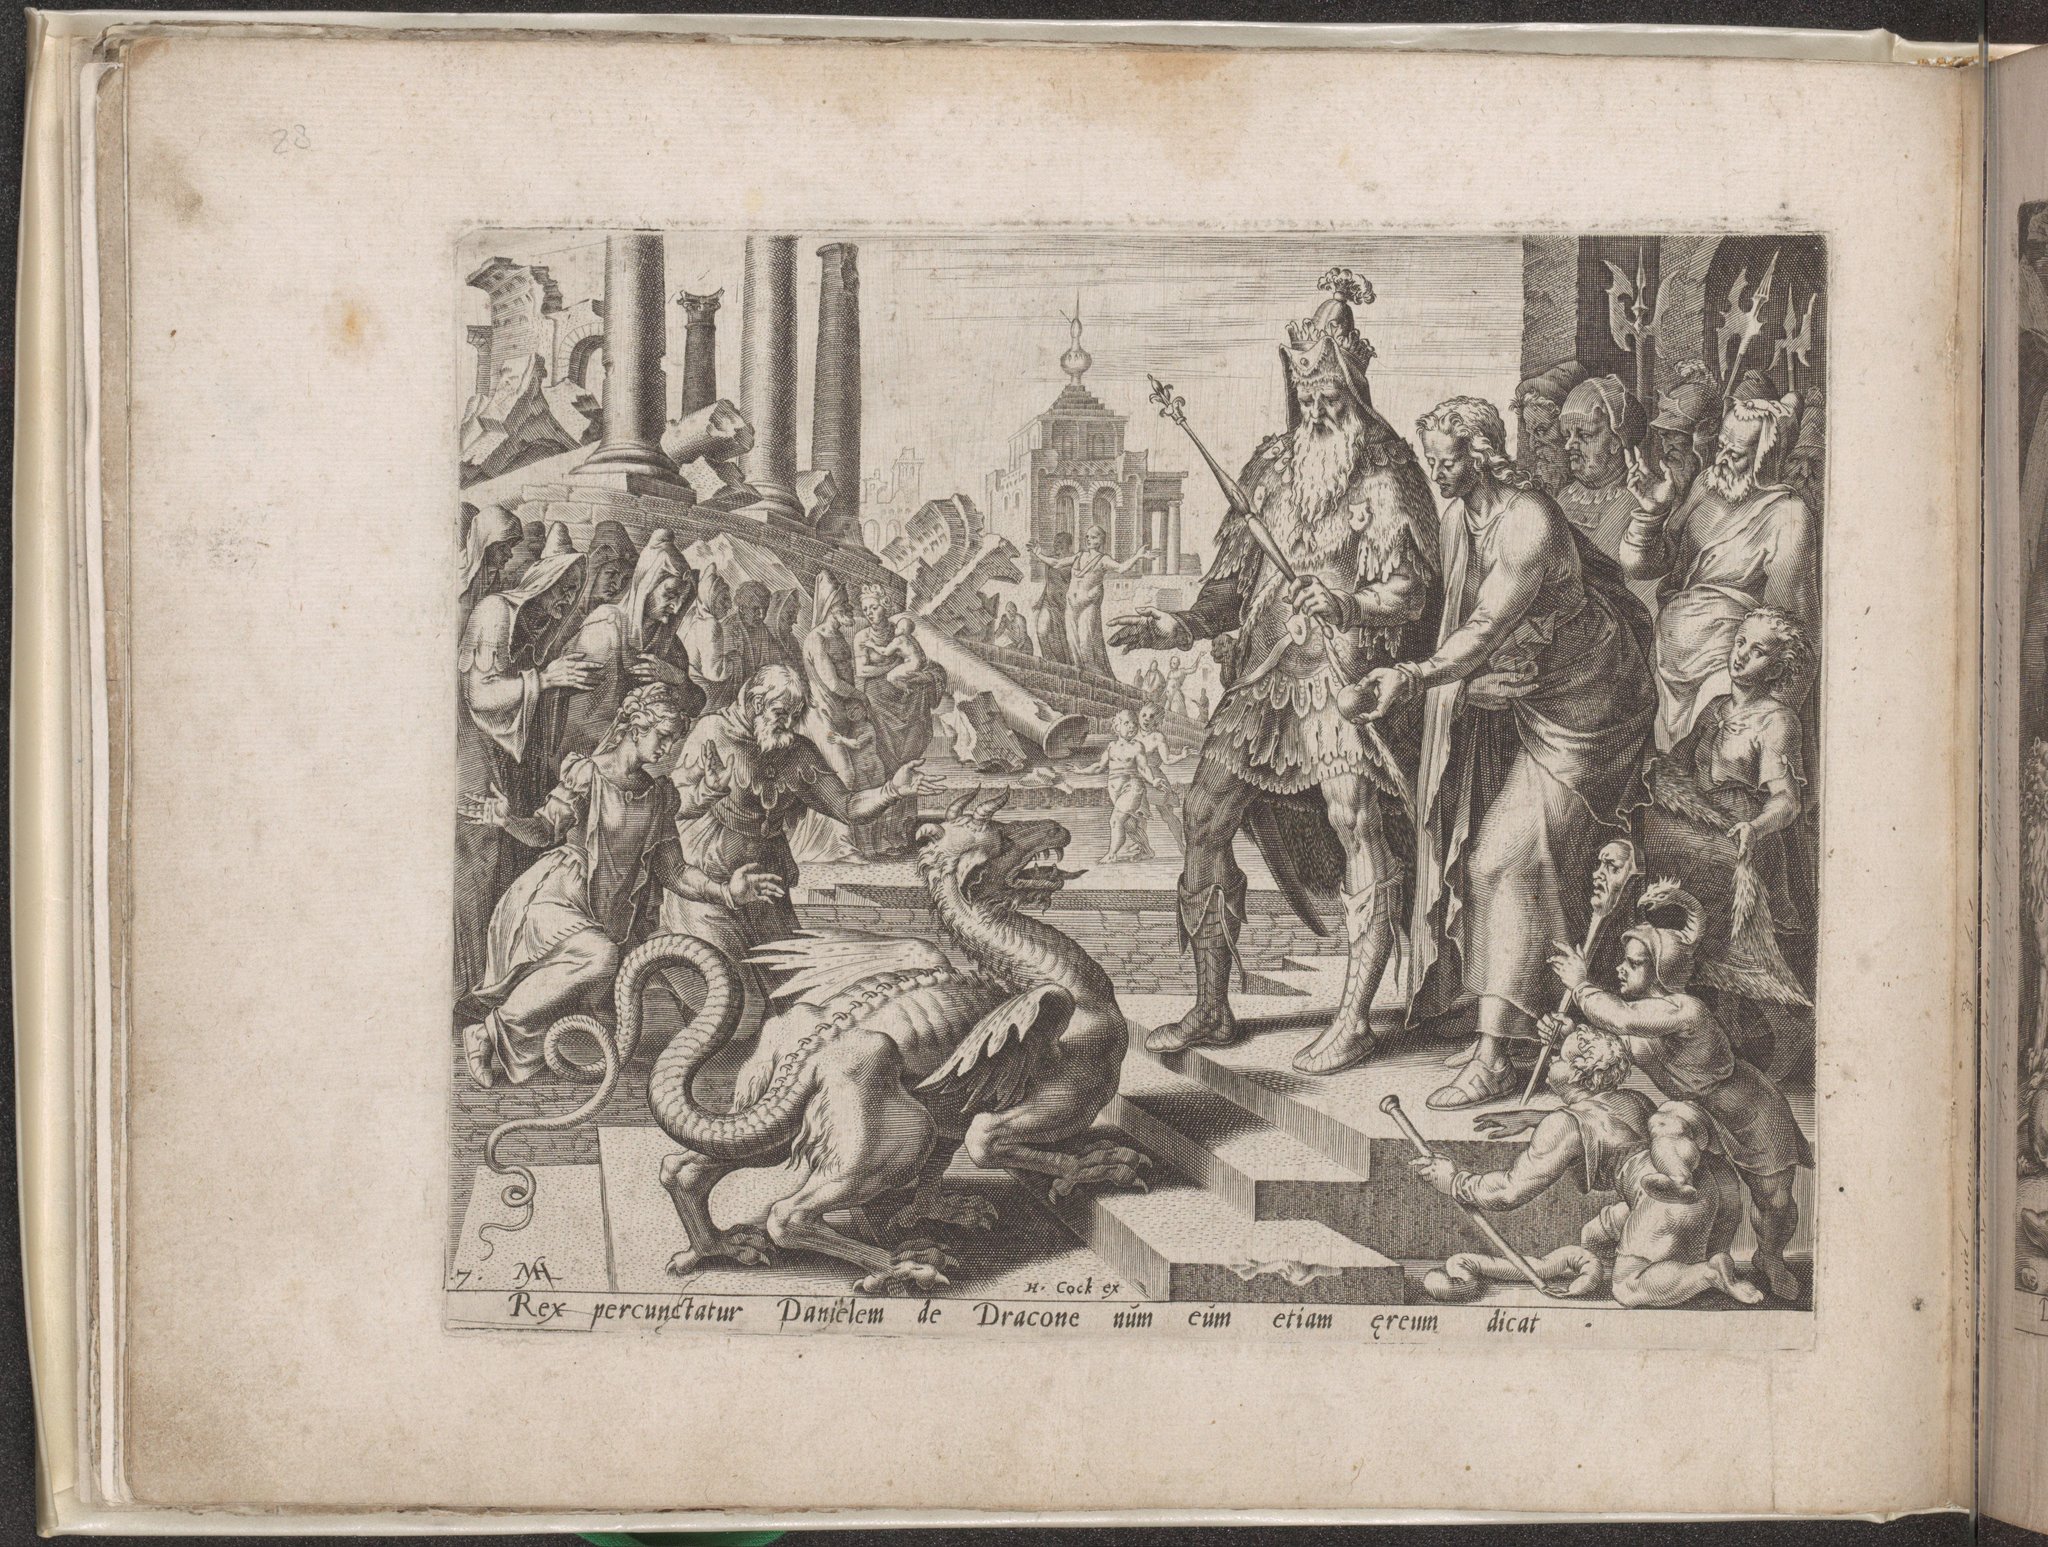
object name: album leaf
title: Daniël voedt de draak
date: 1565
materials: paper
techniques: engraving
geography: antwerp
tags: daniel gives food to the dragon; king cyrus looking on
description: Koning Cyrus vraagt Daniël om de draak als god te vereren. Daniël weigert dit en vraagt toestemming om de draak te doden zonder het gebruik van wapens. Hij voedt de draak met koeken van teer, vet en graten die de draak van binnen openrijten. Onder de voorstelling een verklarende tekst in het Latijn. Deze prent maakt deel uit van een album.